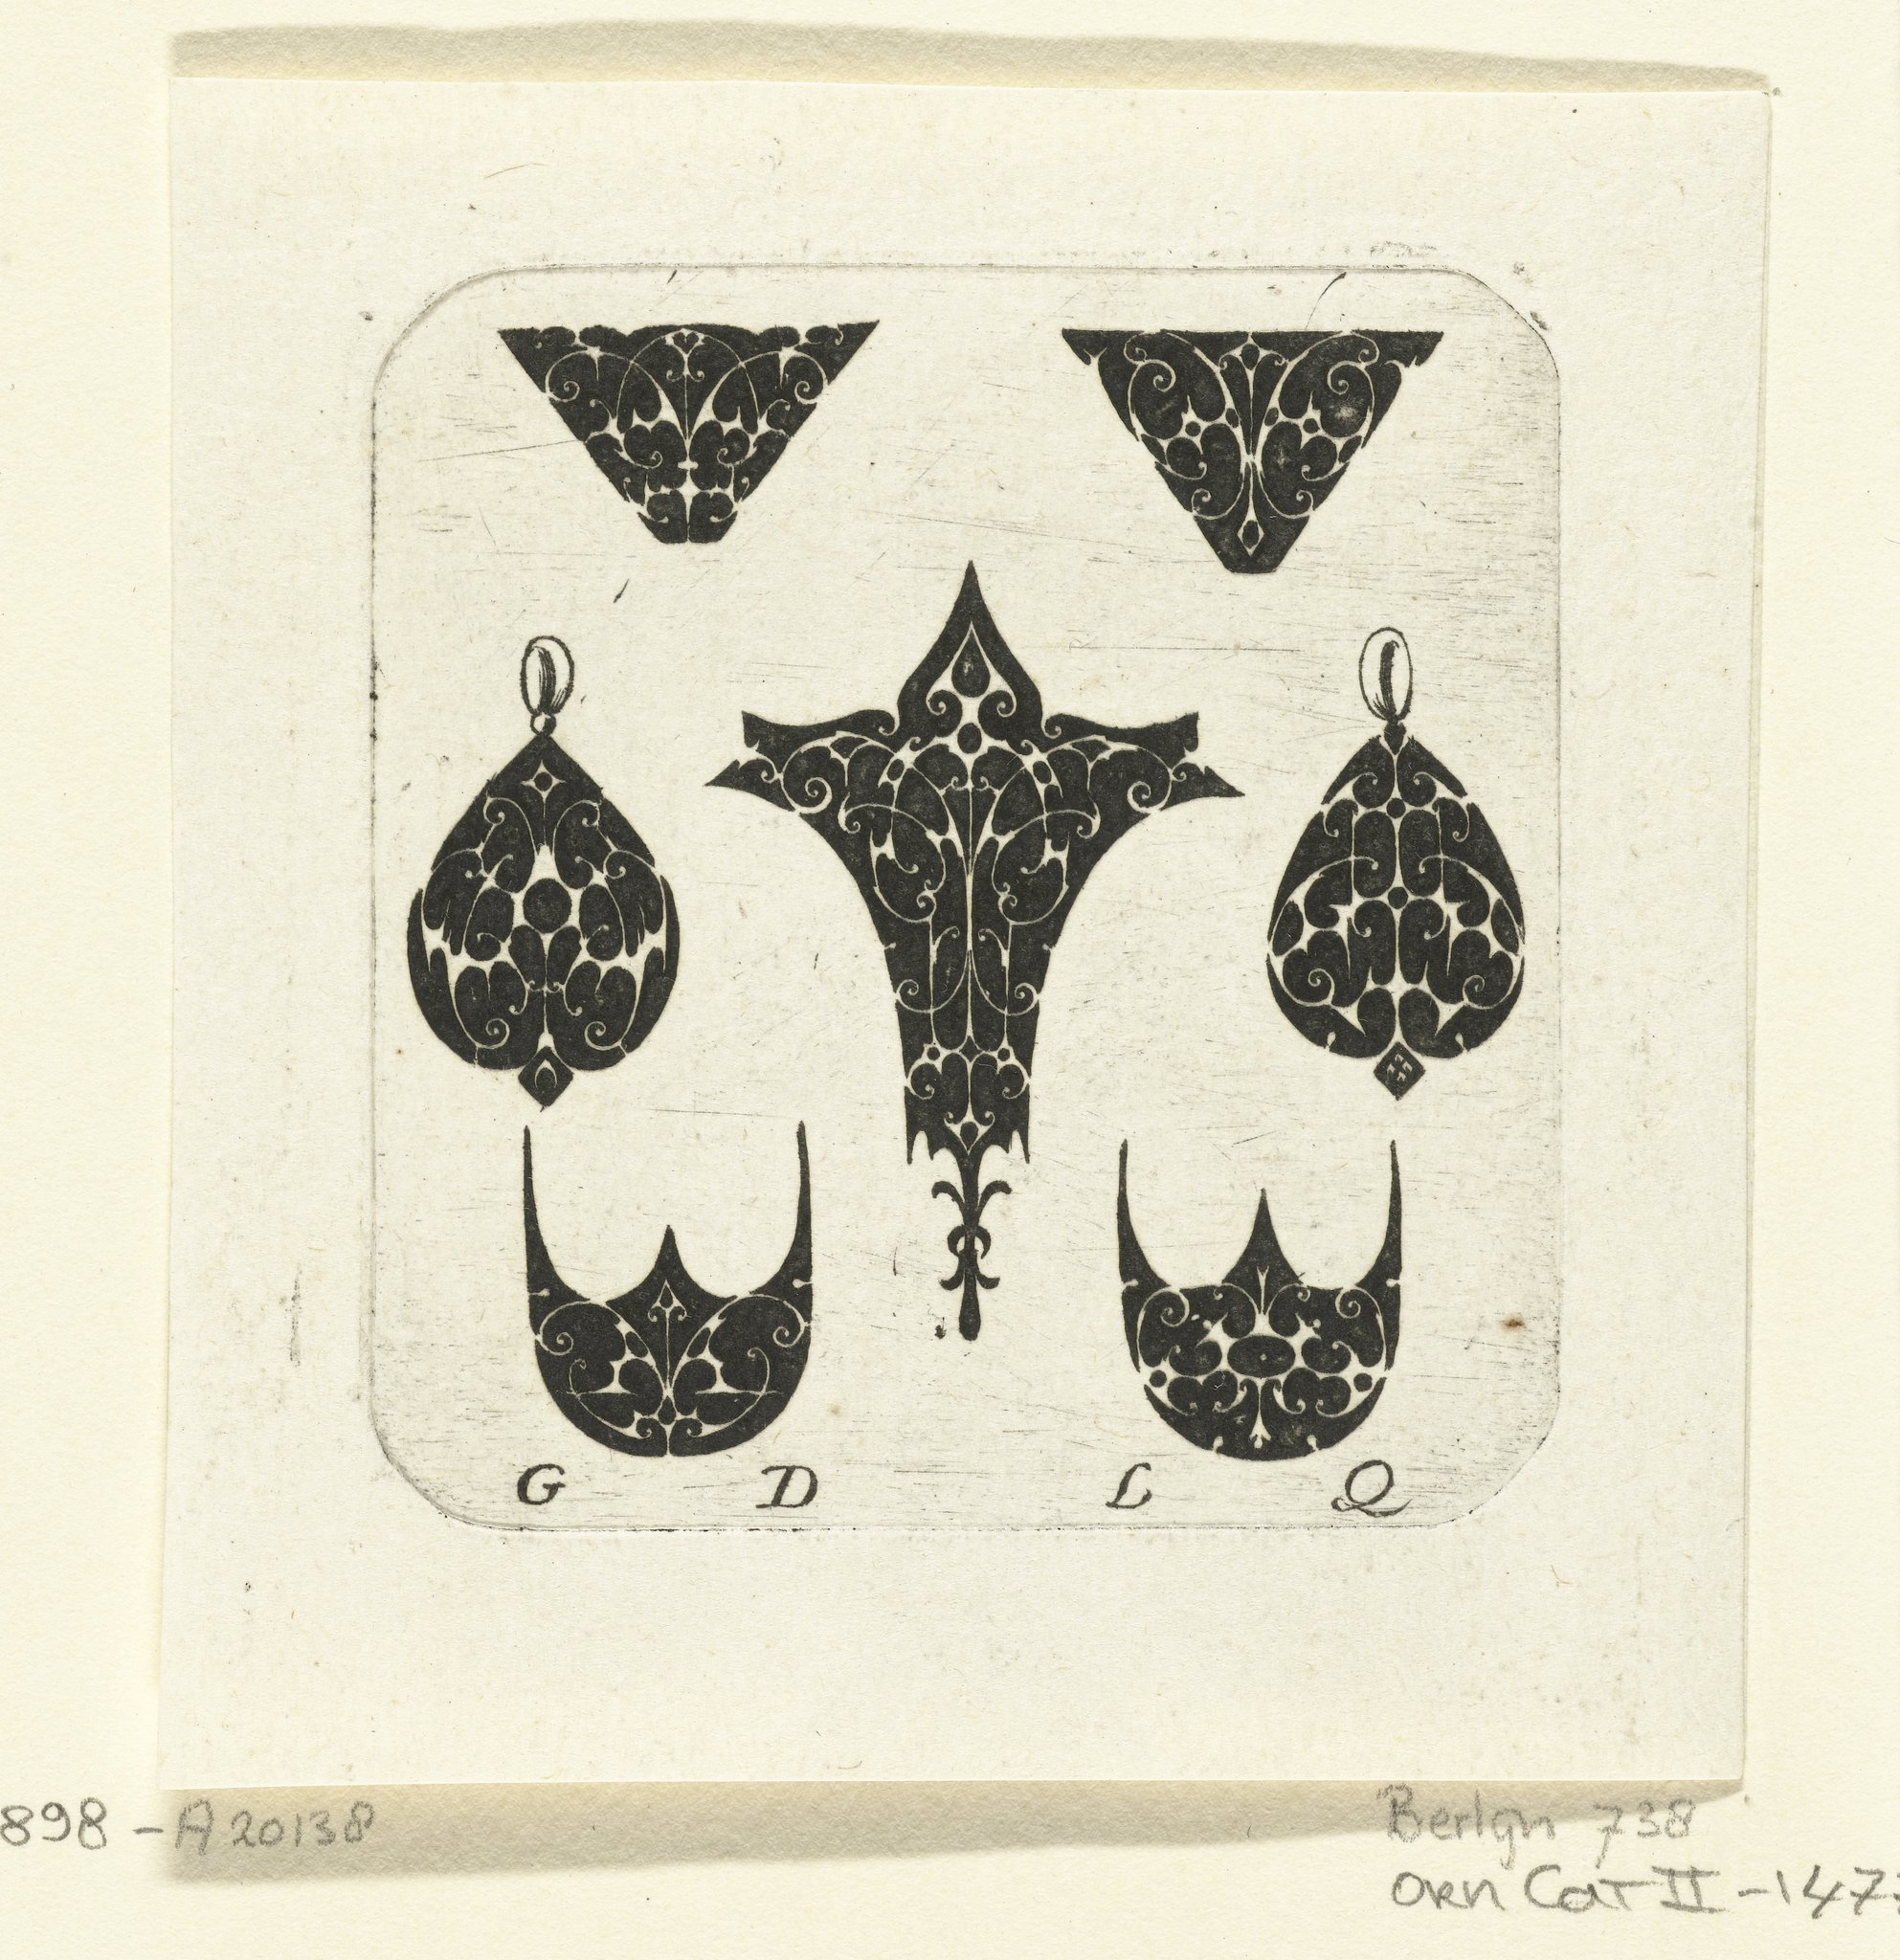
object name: ornament print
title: Sieraadontwerpen voor emailleurs in de vorm van zwartornamenten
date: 1611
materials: paper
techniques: engraving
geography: amsterdam